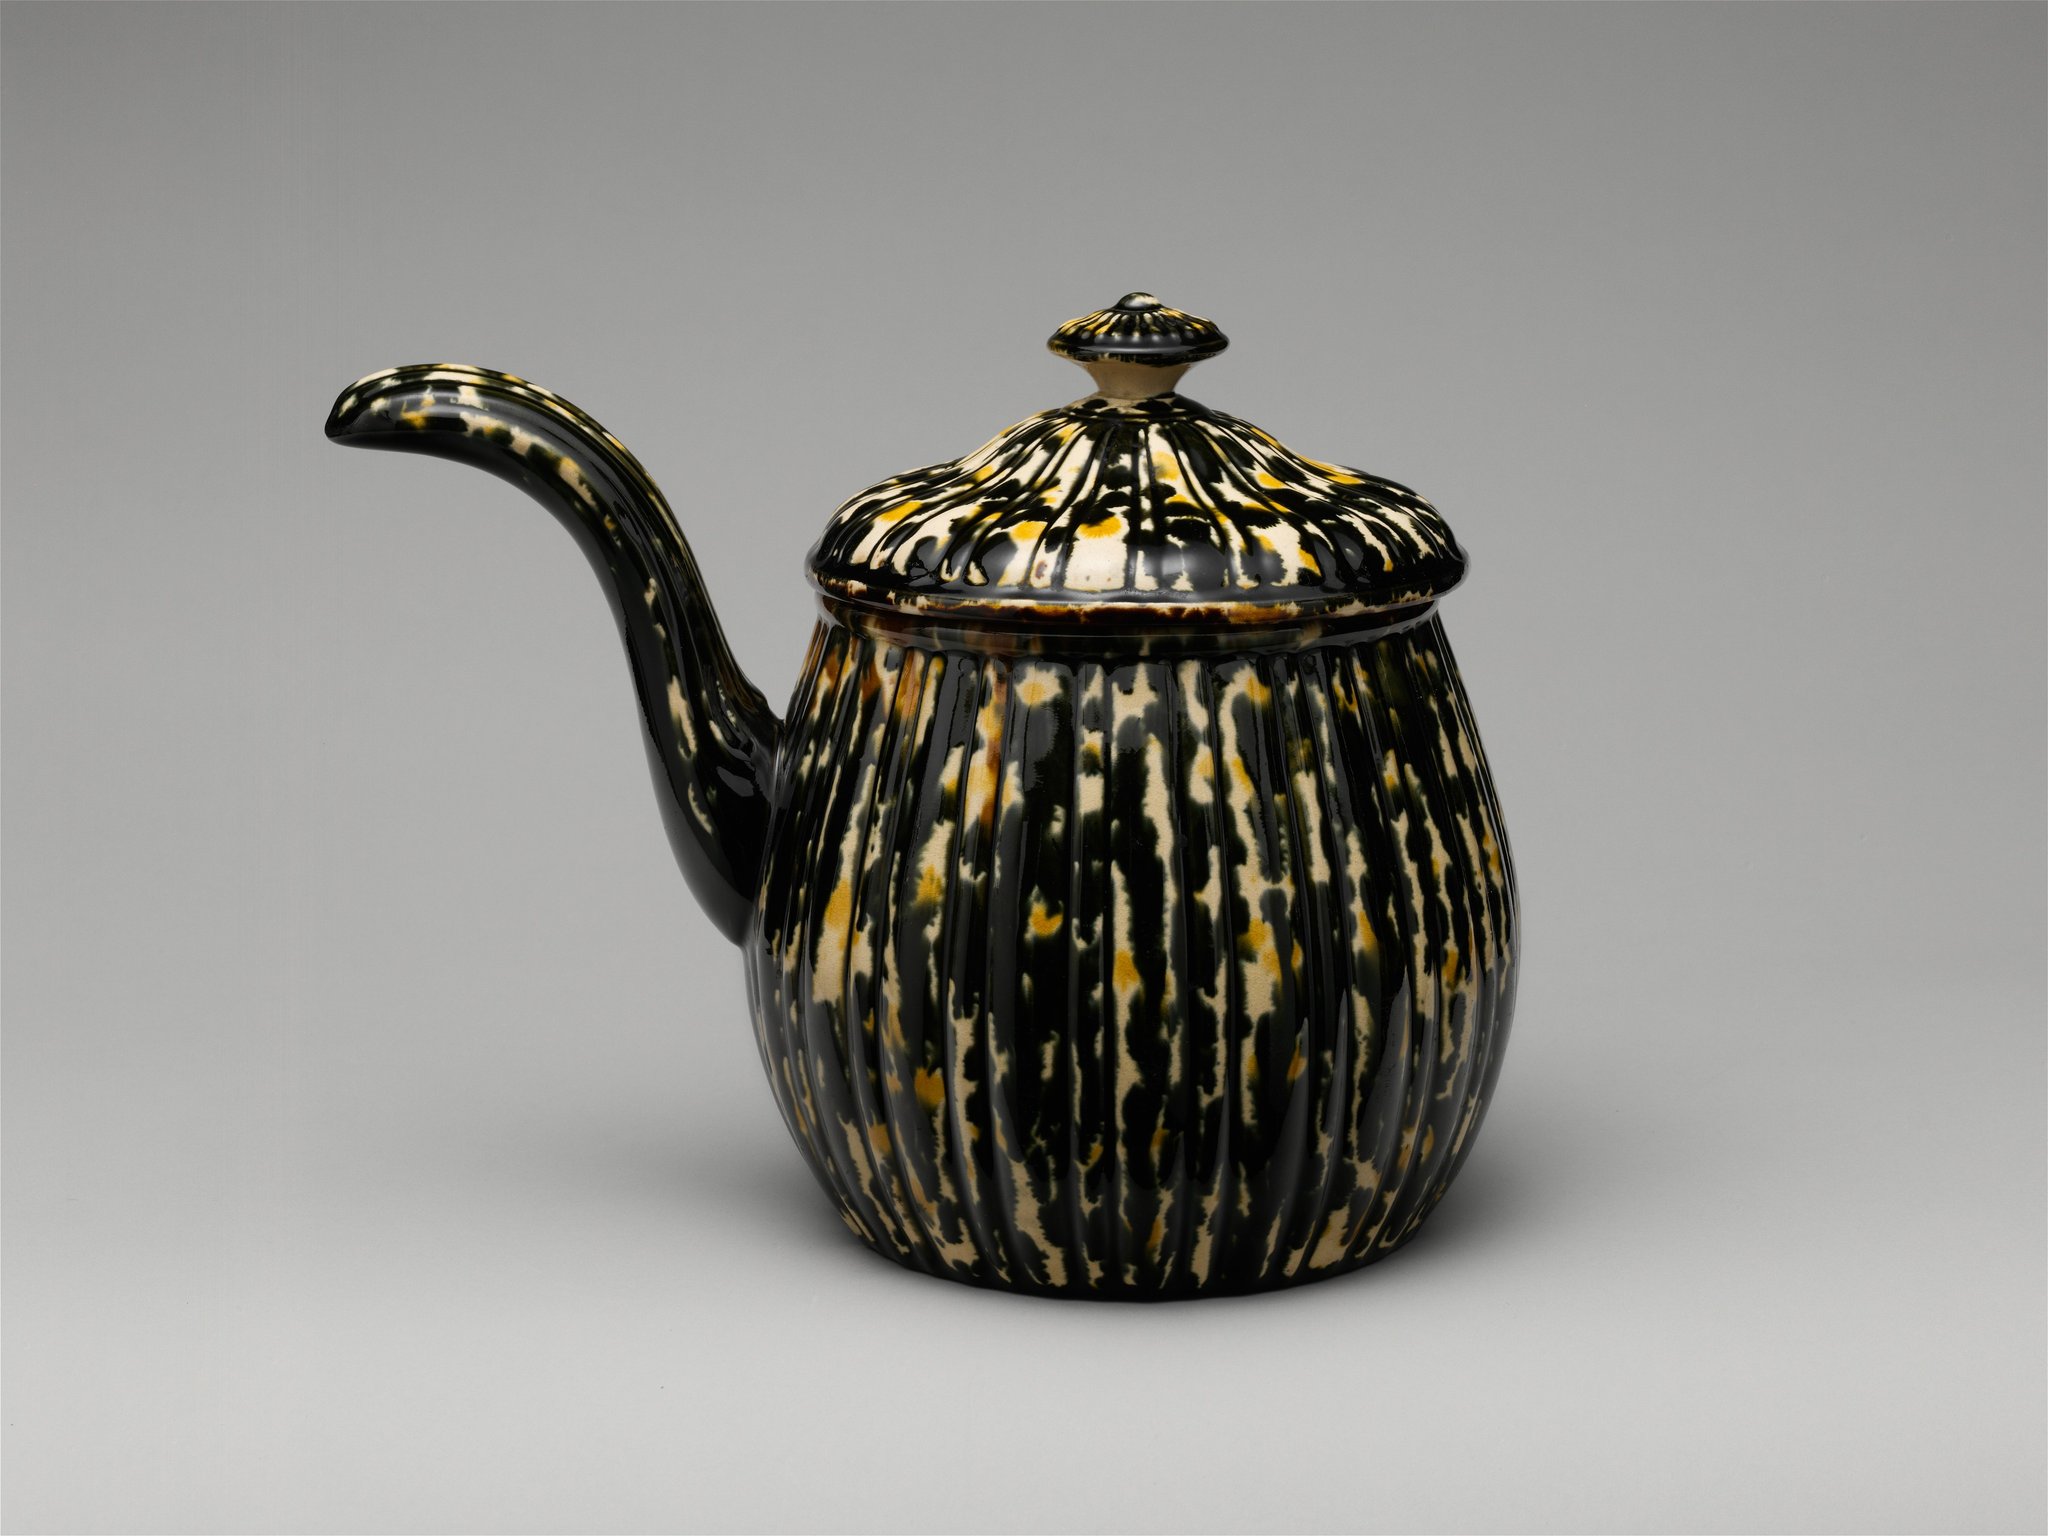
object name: bean pot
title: Covered bean pot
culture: american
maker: lyman, fenton & co.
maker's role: manufacturer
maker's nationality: american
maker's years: 1849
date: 1849-1852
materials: earthenware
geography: united states